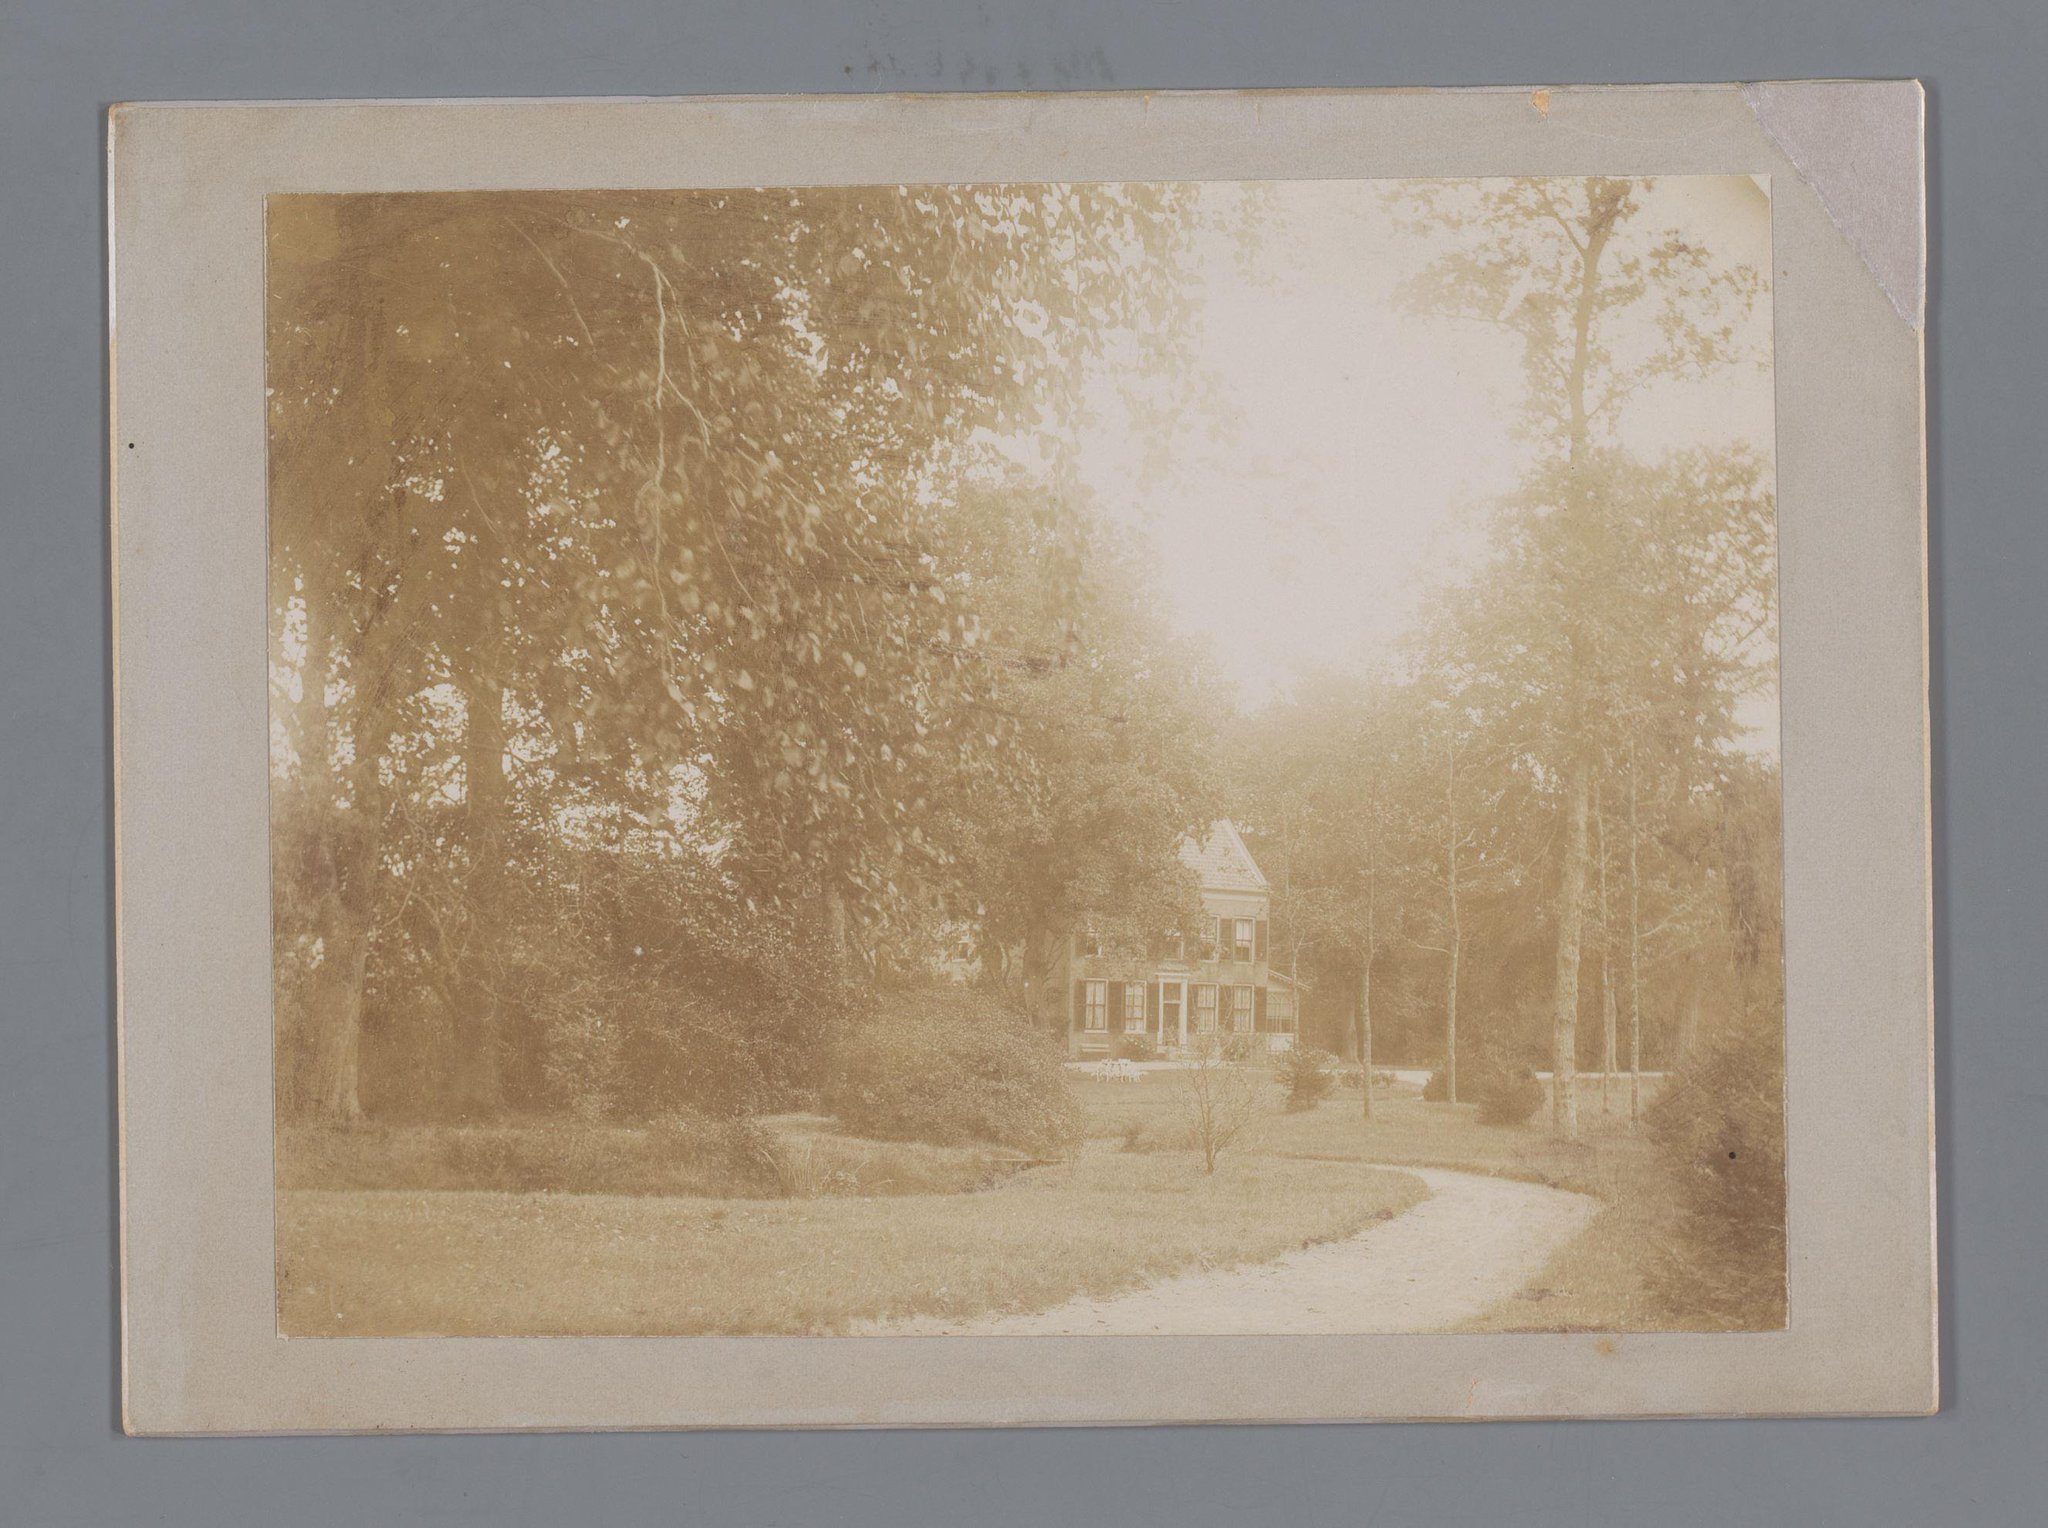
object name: photograph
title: Gezicht op buitenplaats Rustenhoven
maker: cornelia hendrika jonker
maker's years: 1874-1924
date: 1880-1920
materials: cardboard, photographic support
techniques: collodion silver print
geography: maartensdijk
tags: garden, rural housing, e.g. country-house, villa, cottage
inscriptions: annotation: ‘J.D. van der Waals’